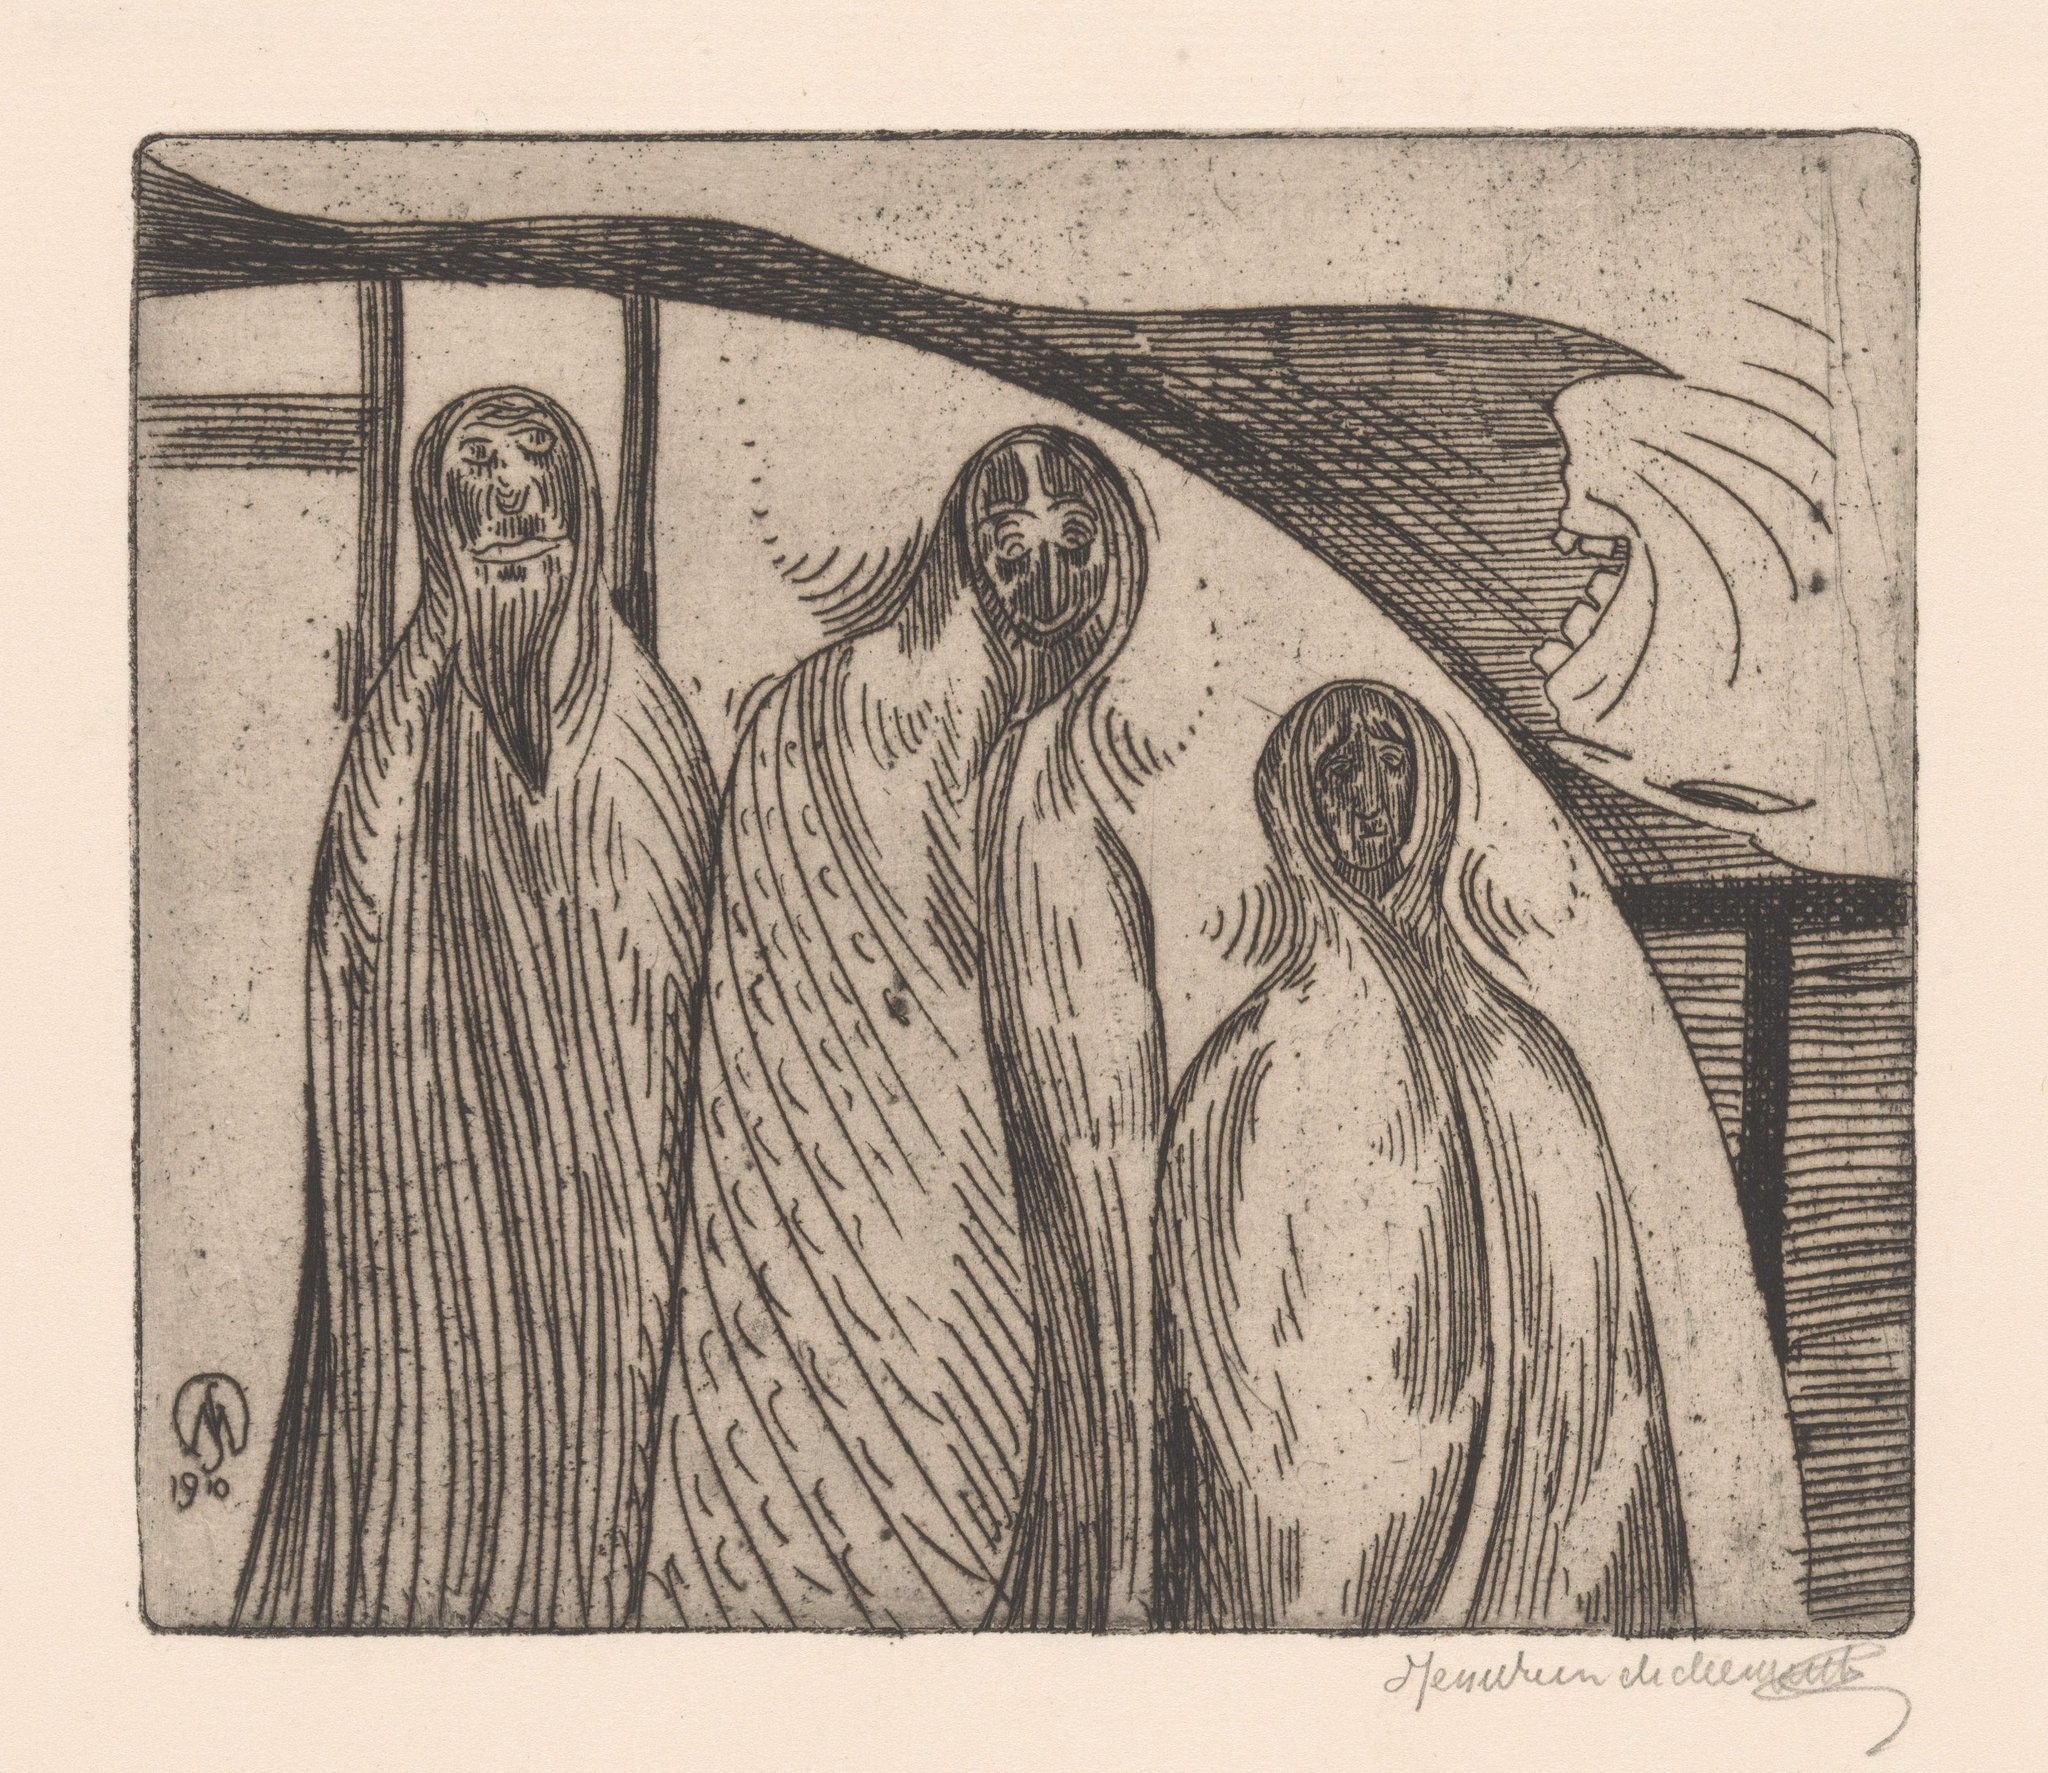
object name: print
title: Drie langgerekte figuren in mantels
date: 1910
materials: paper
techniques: etching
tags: mouth wide open, caricatures (human types), coat, cape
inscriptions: collector's mark: Lugt 2228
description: De linker figuur heeft een baard. Rechtsboven een omgekeerd gezicht met open mond.